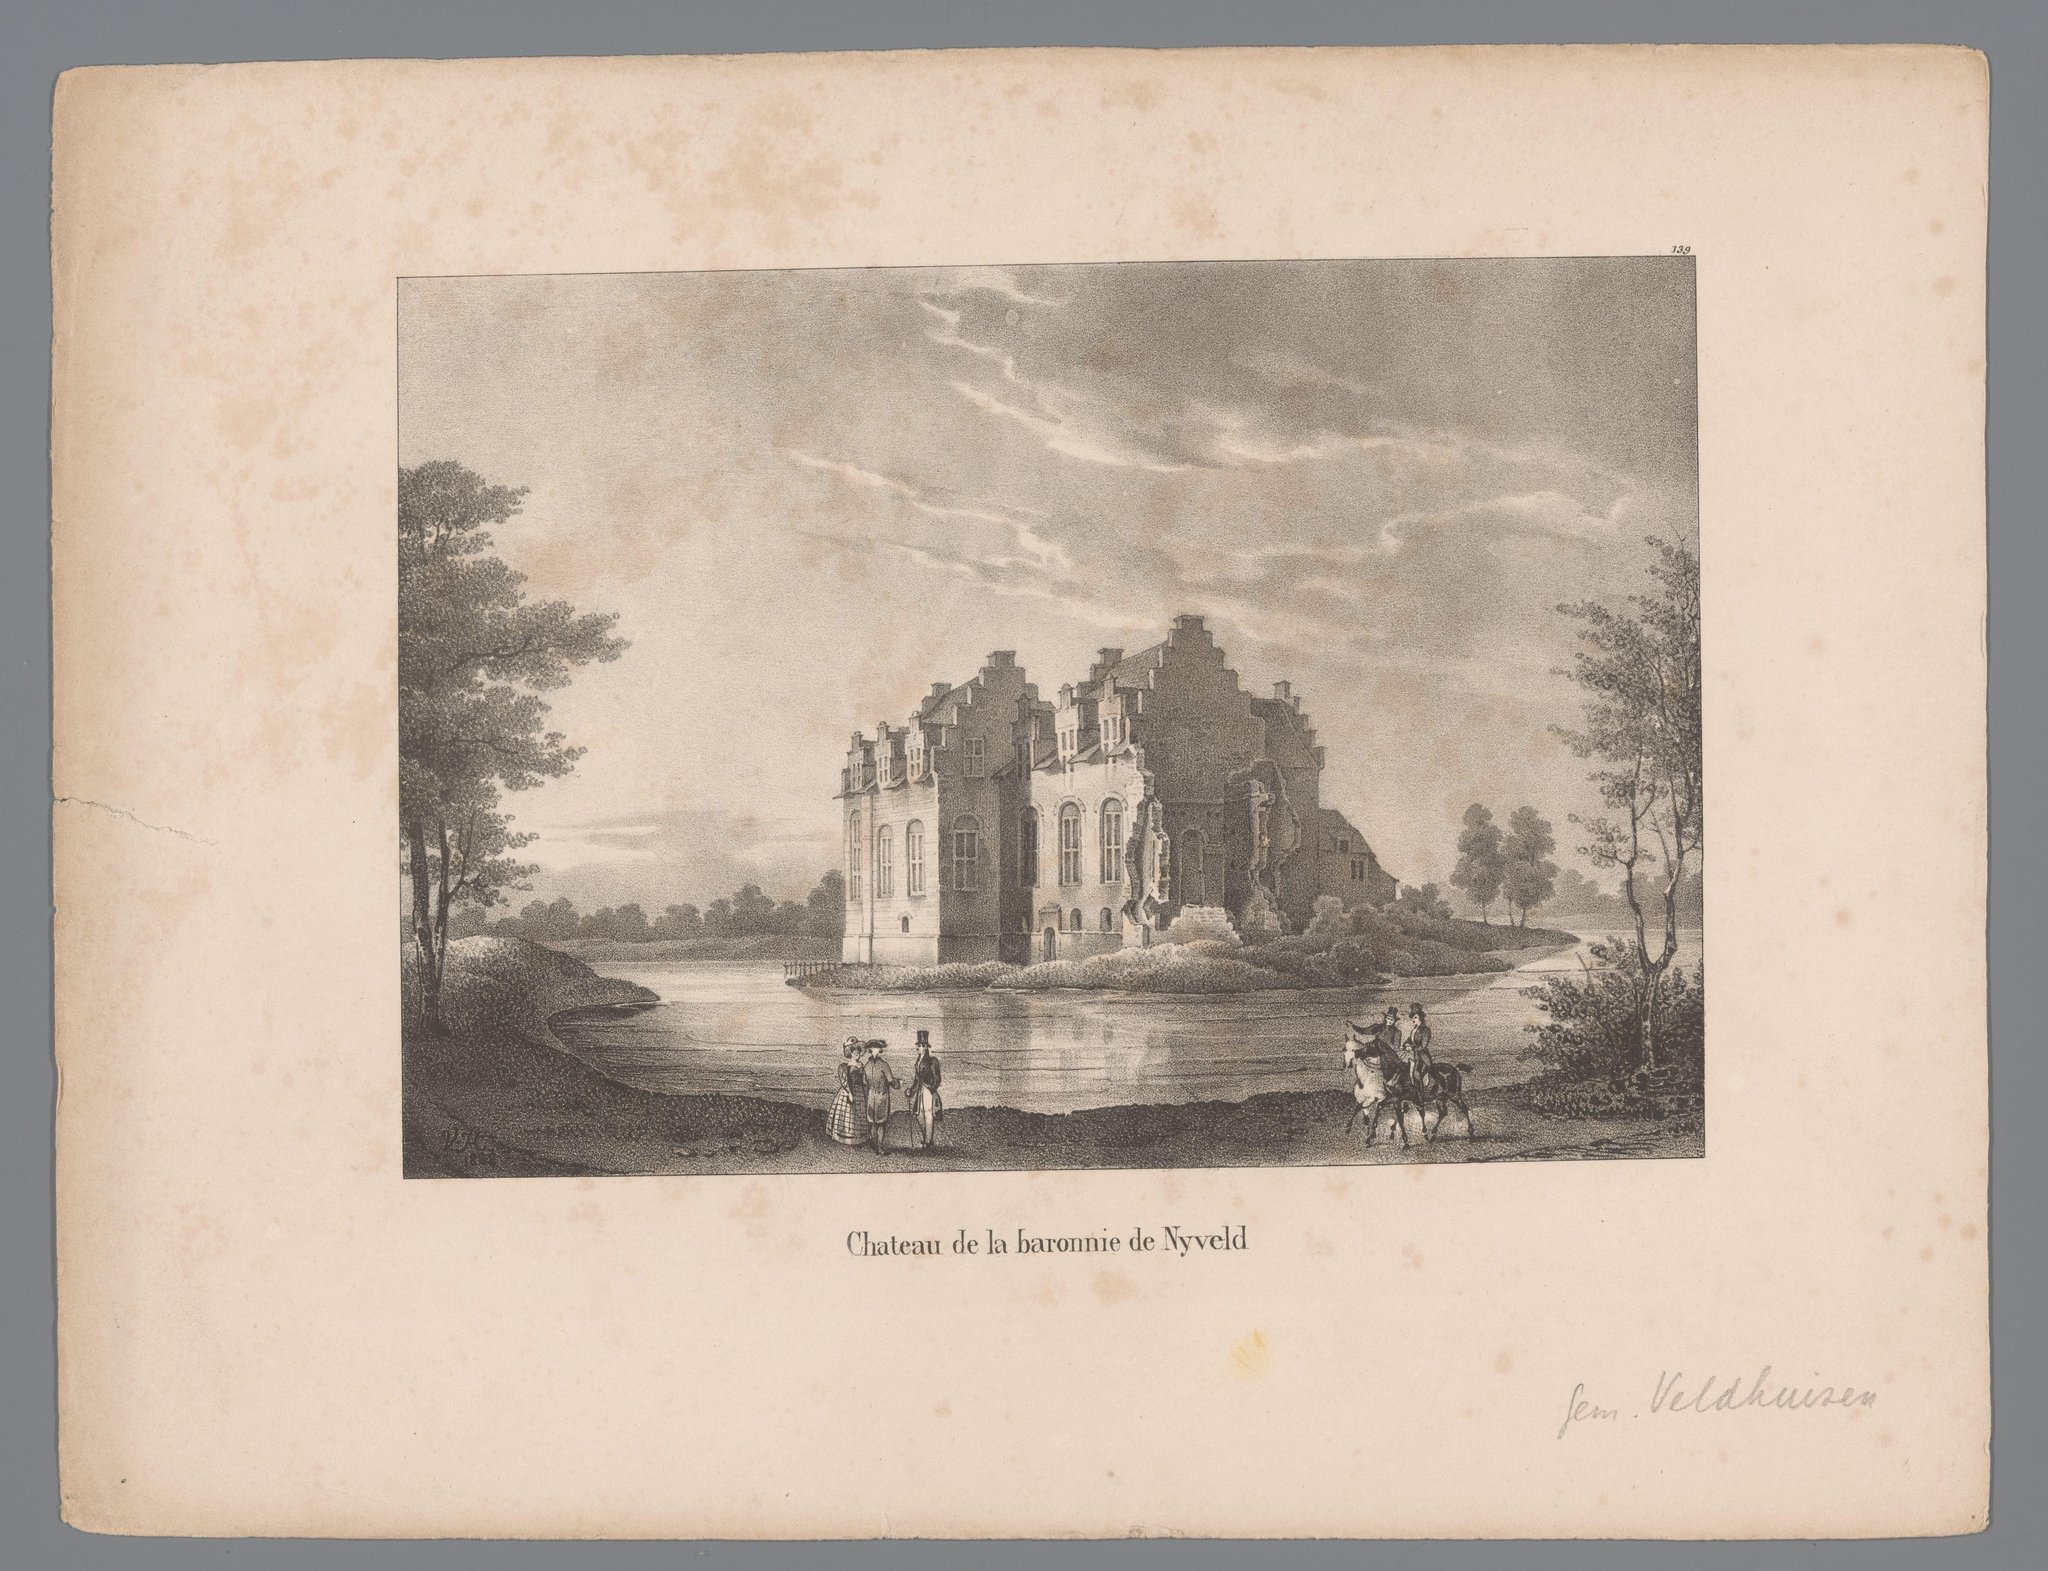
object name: print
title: Gezicht op de ridderhofstad Nijeveld bij de Meern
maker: Anonymous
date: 1828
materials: paper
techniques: lithograph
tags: castle, landscape with tower or castle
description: Linksonder gemonogrammeerd en gedateerd "V.H.J. 1828".